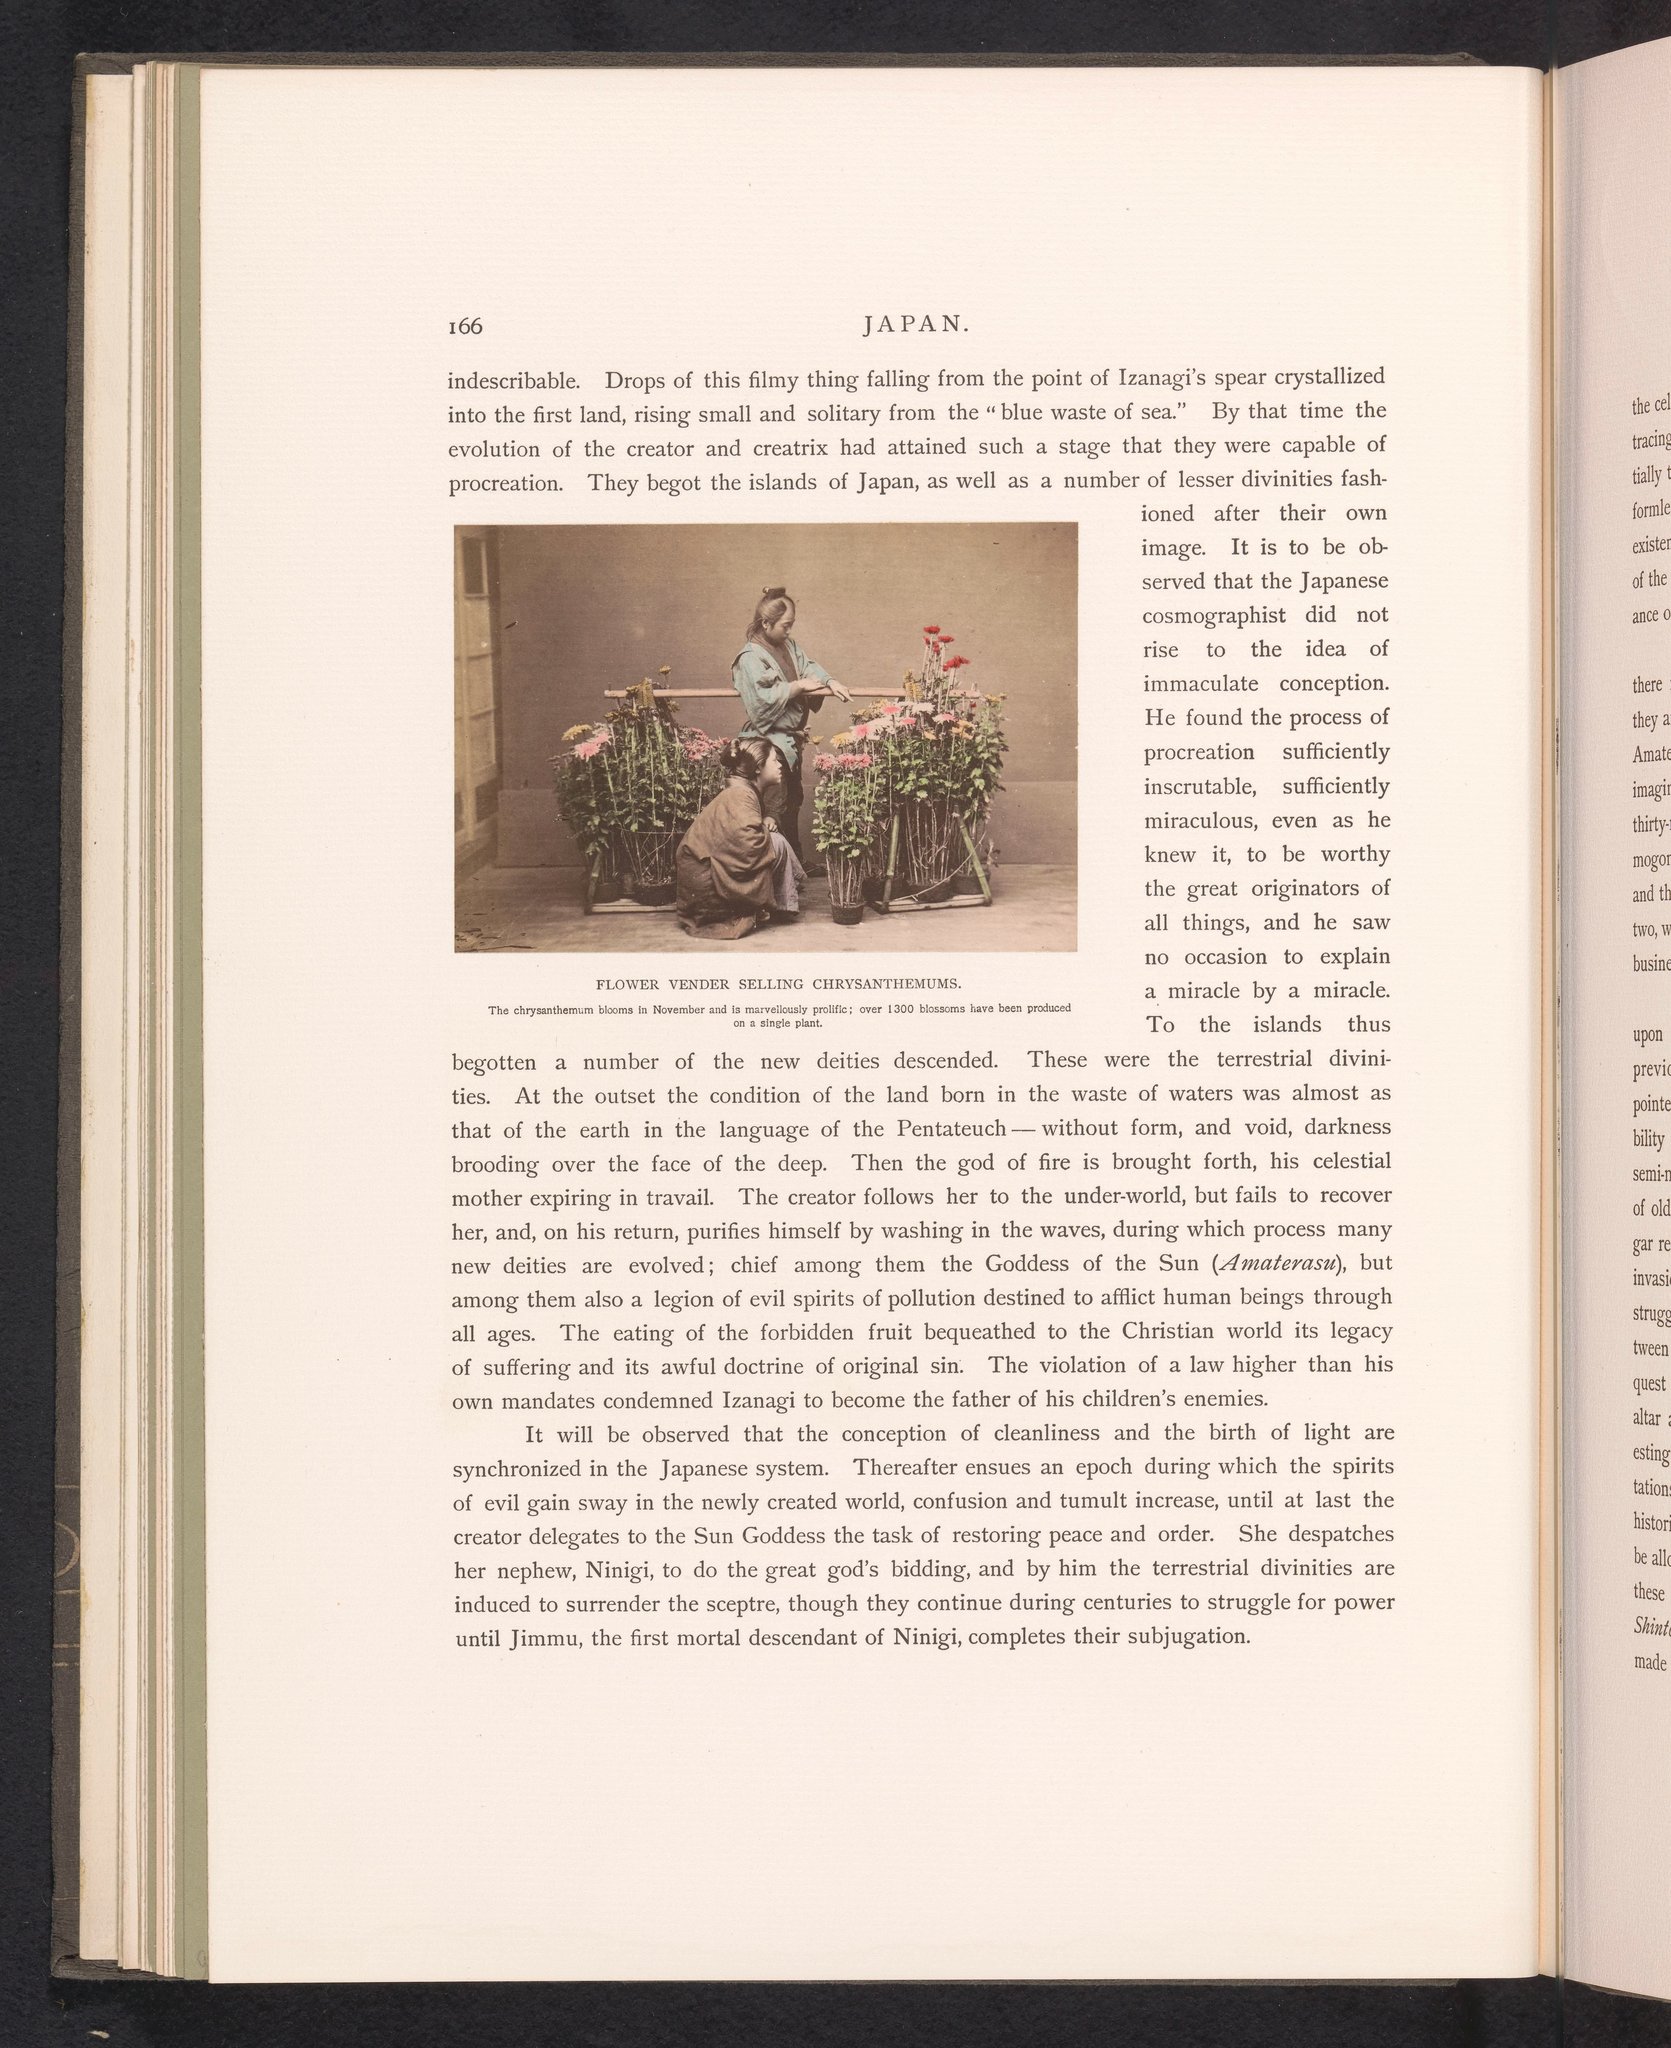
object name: photograph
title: Flower vender selling chrysantemums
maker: Anonymous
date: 1887-1897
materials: photographic support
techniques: albumen print, hand coloring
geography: yokohama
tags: flowers, merchant, salesman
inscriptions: inscription: ‘The chrysanthemum blooms in November and is marvellously prolific; over 1300 blossoms have been produced on a single plant.’